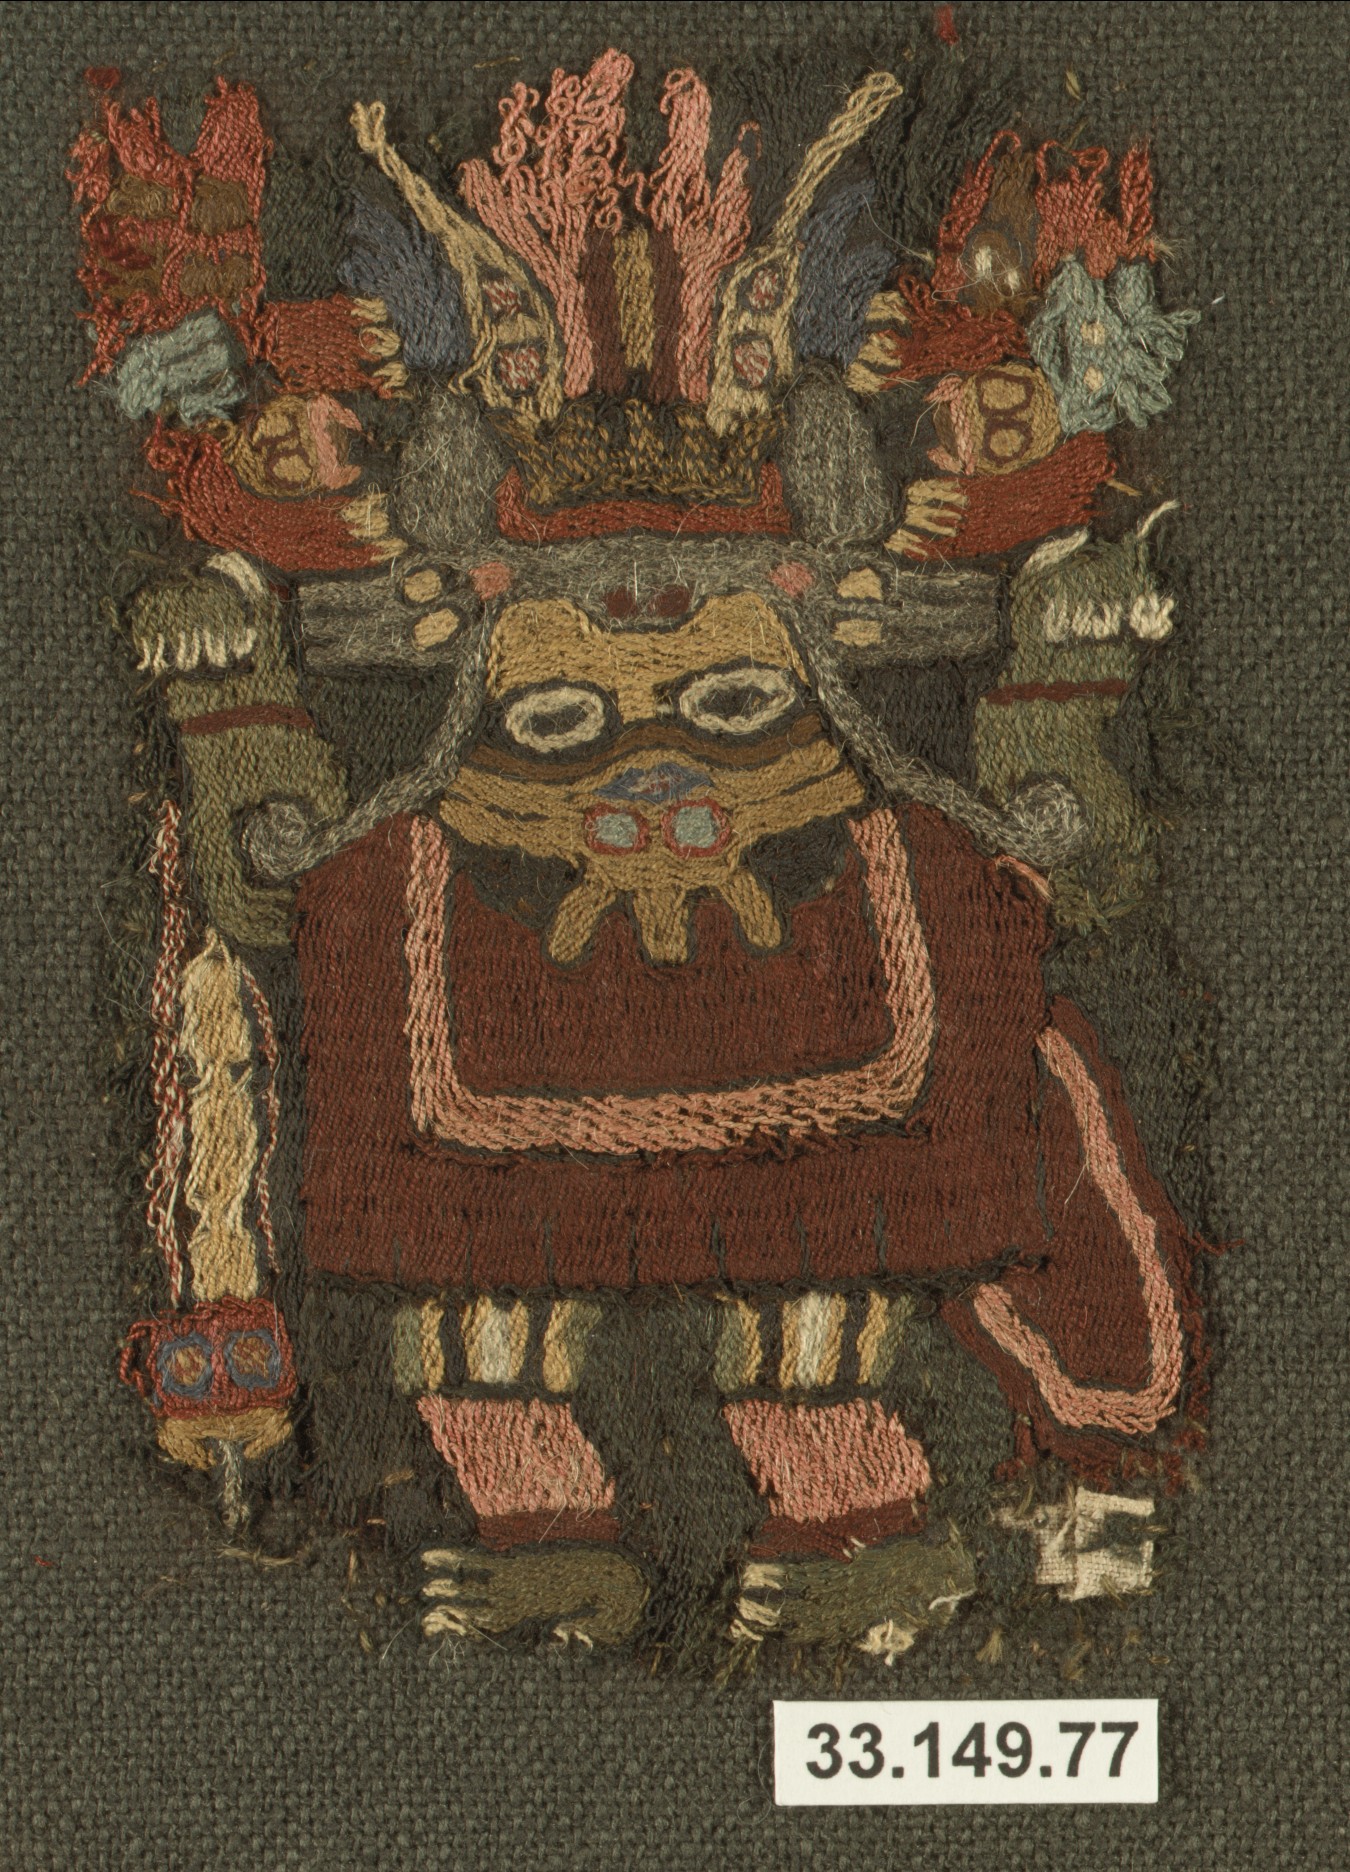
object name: mantle fragment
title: Embroidered Mantle Fragment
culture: paracas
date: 300-101 BCE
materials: animal fiber, cotton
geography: peru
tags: heads,mythical creatures